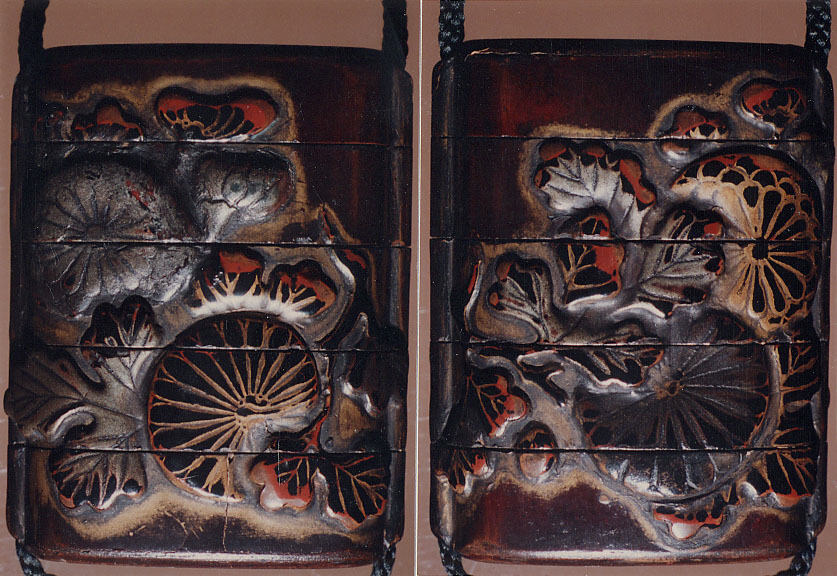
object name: inrō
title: Case (Inrō) with Design of Chrysanthemums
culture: japanese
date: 1601-1800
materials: gold, lacquer, silver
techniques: fundame, hiramakie, maki-e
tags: flowers